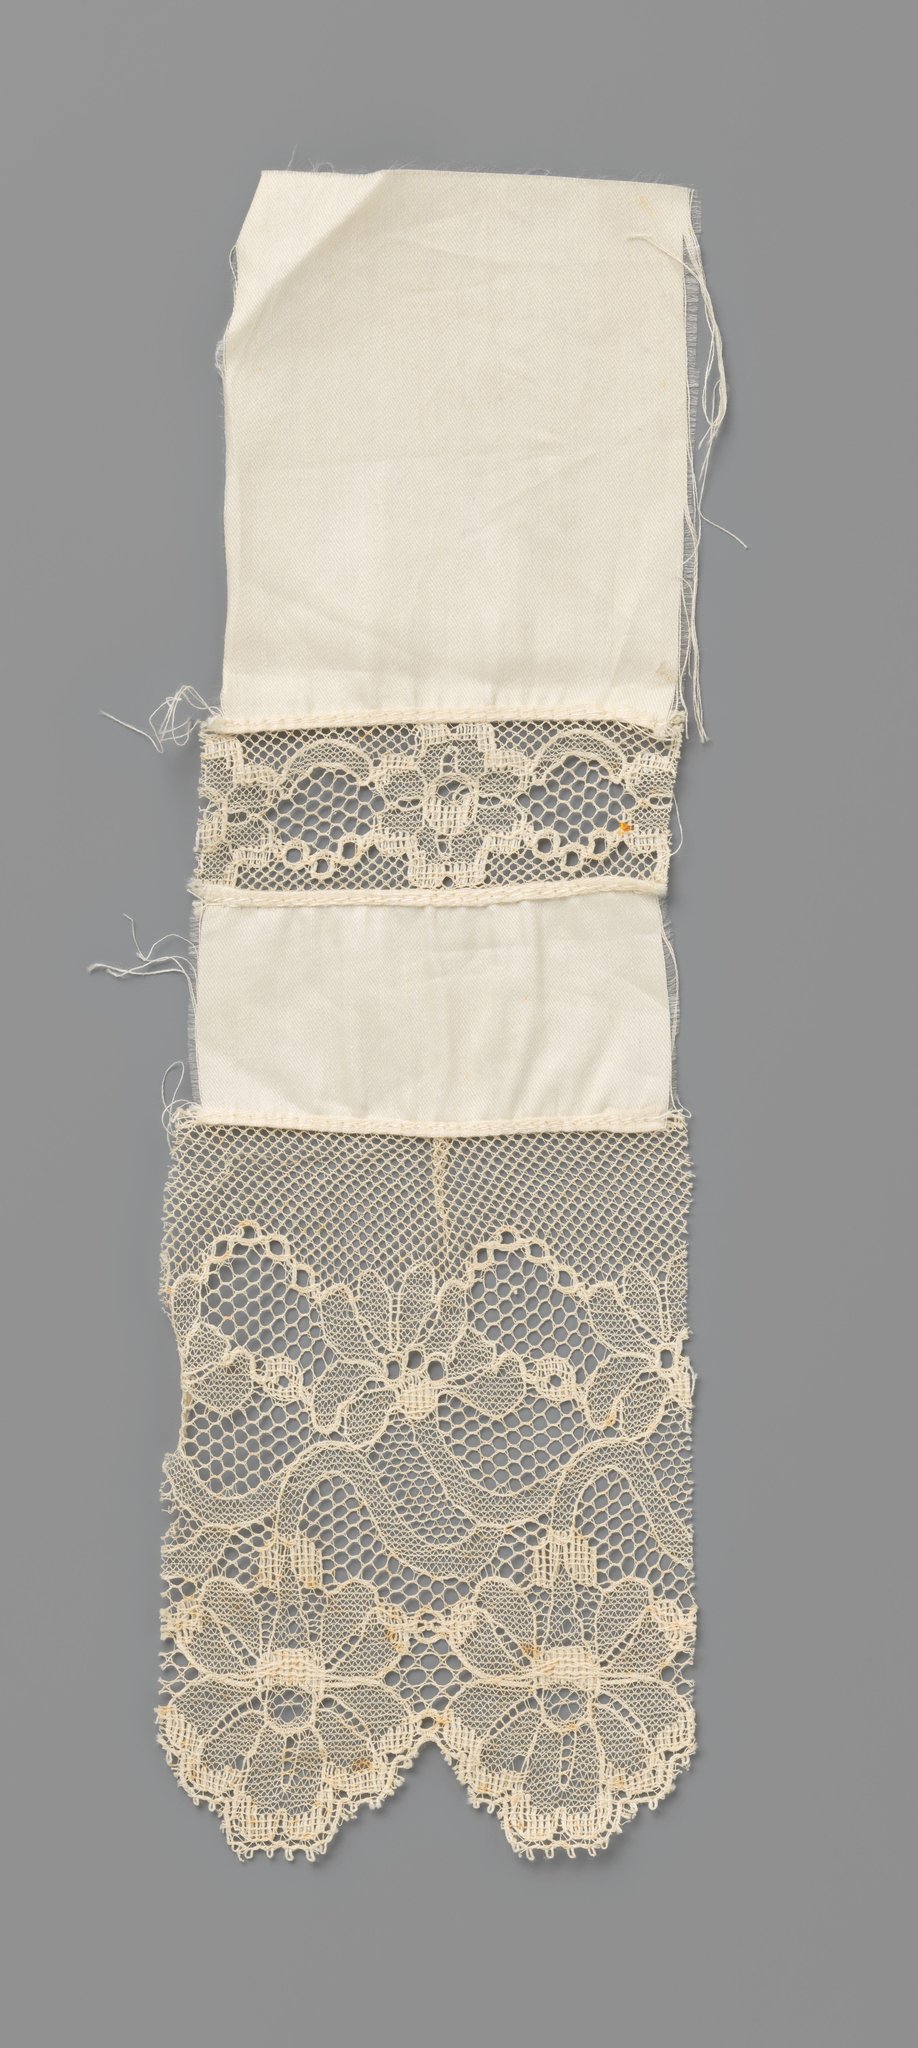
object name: fragment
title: Fragment van wit satijn met tussenzetsel van machinale kant met patroon van aaneengeschakelde bloemen en een strook geschulpte en gepicoteerde machinale kant met bloempatroon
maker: gustav schnitzler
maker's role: paraplufabrikant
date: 1925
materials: cardboard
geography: nijmegen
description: Fragment van wit satijn met tussenzetsel van machinale kant met patroon van aaneengeschakelde bloemen en een strook geschulpte en gepicoteerde machinale kant met bloempatroon.